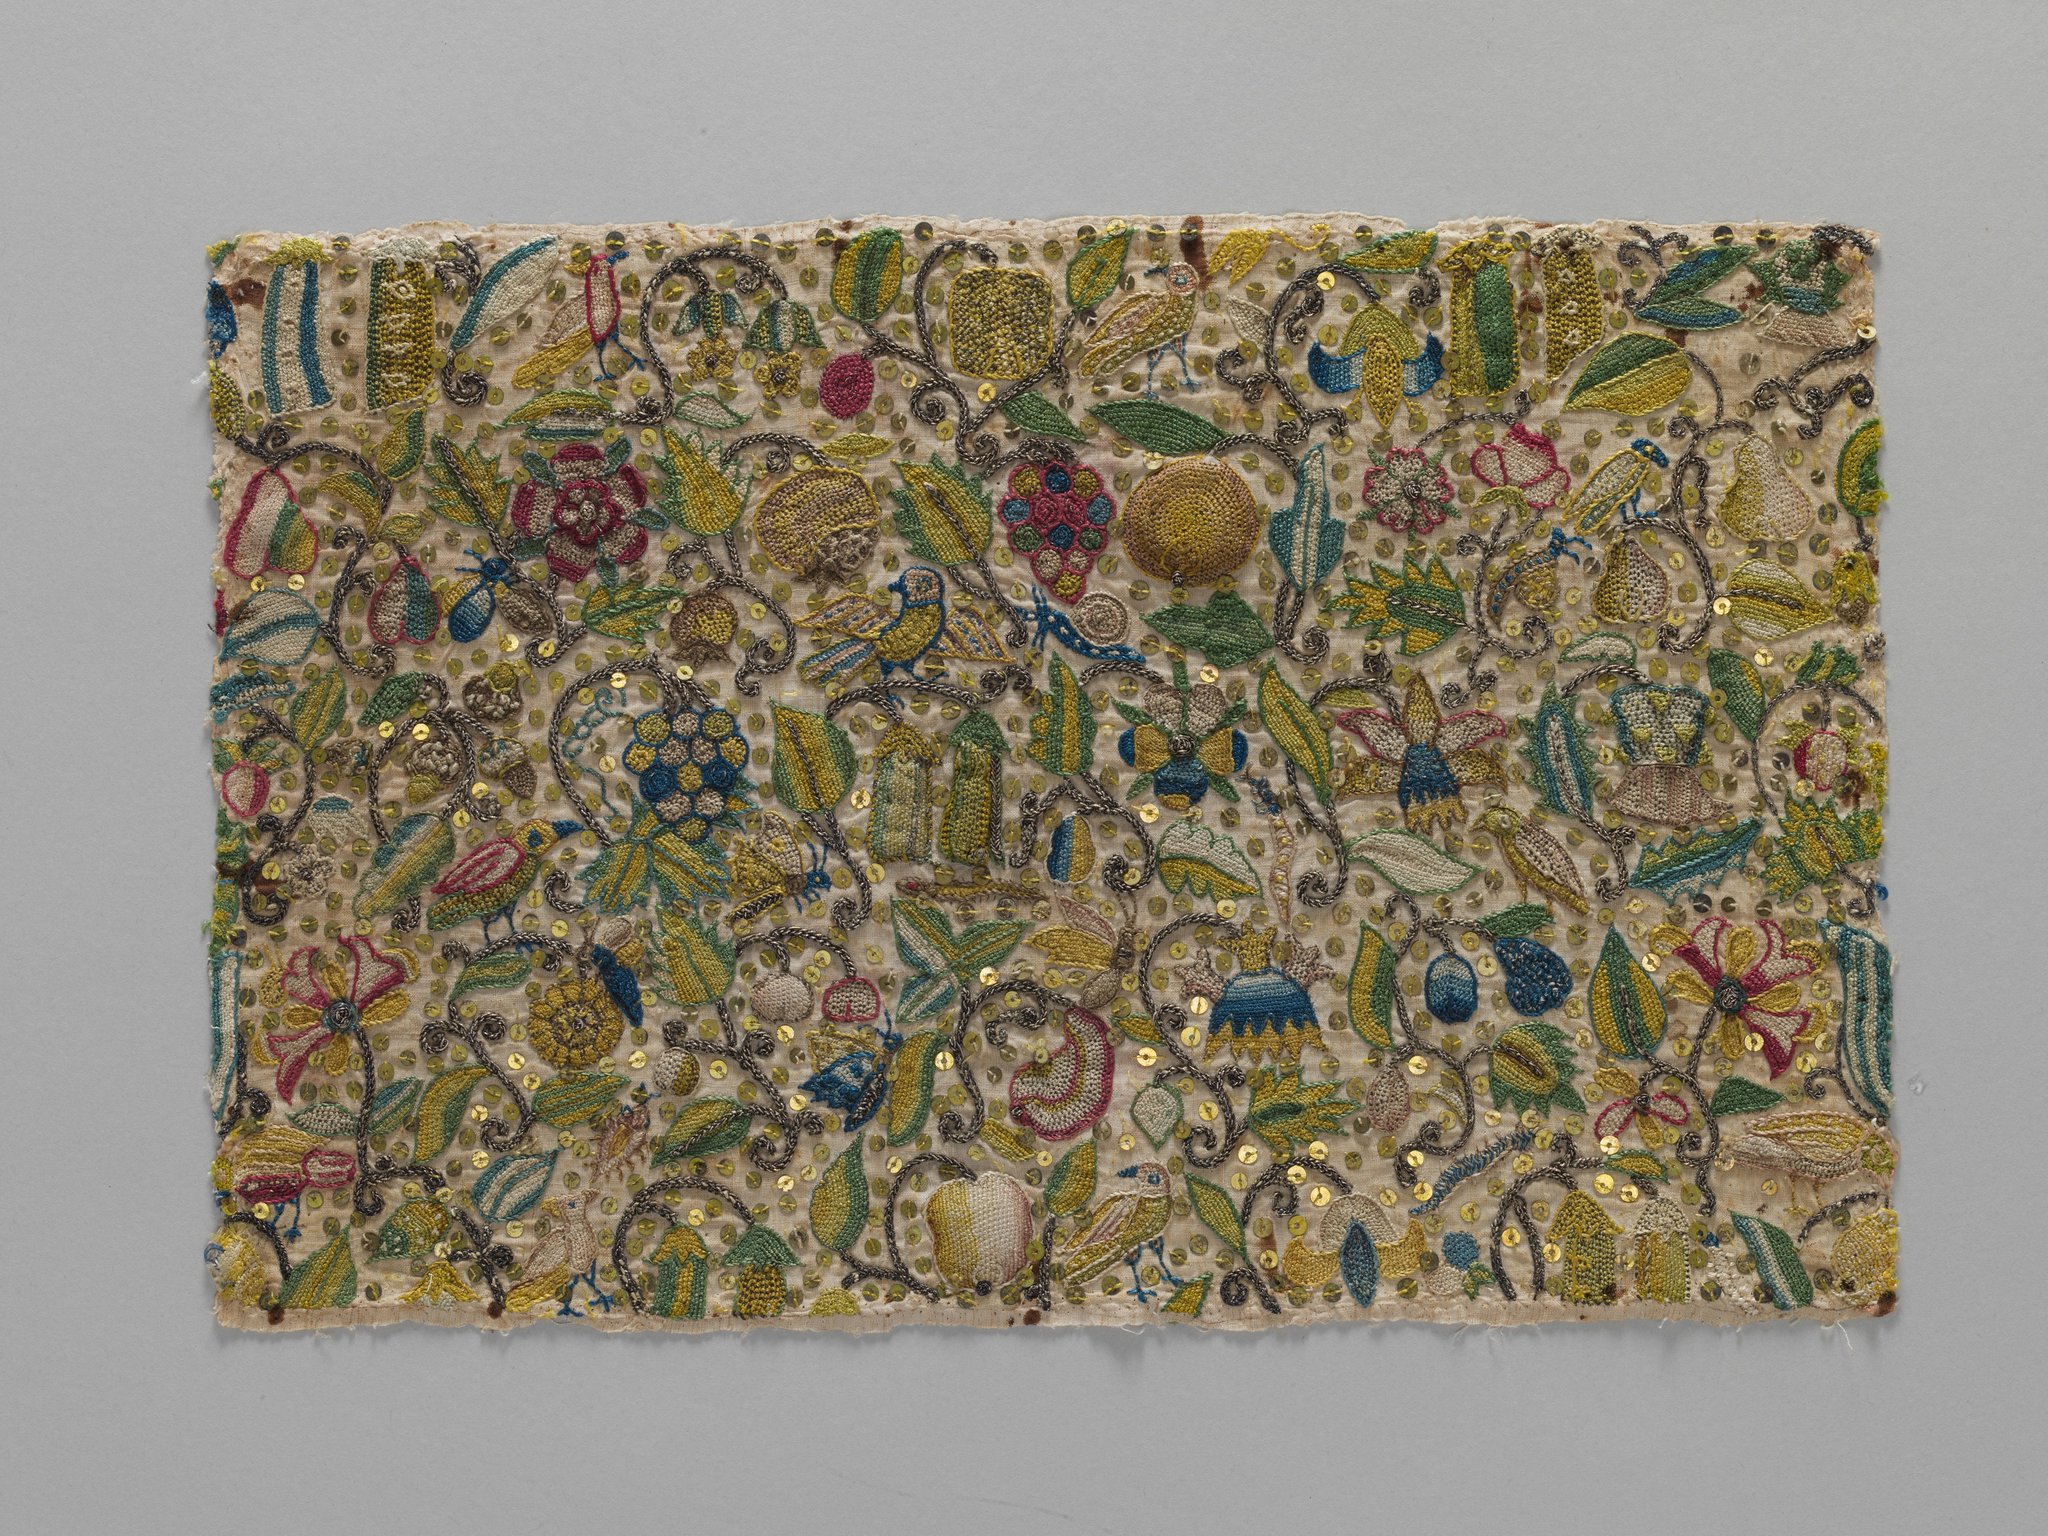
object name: pillow cover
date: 1590-1610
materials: linen, metal thread, silk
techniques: stitching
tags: birds,flowers